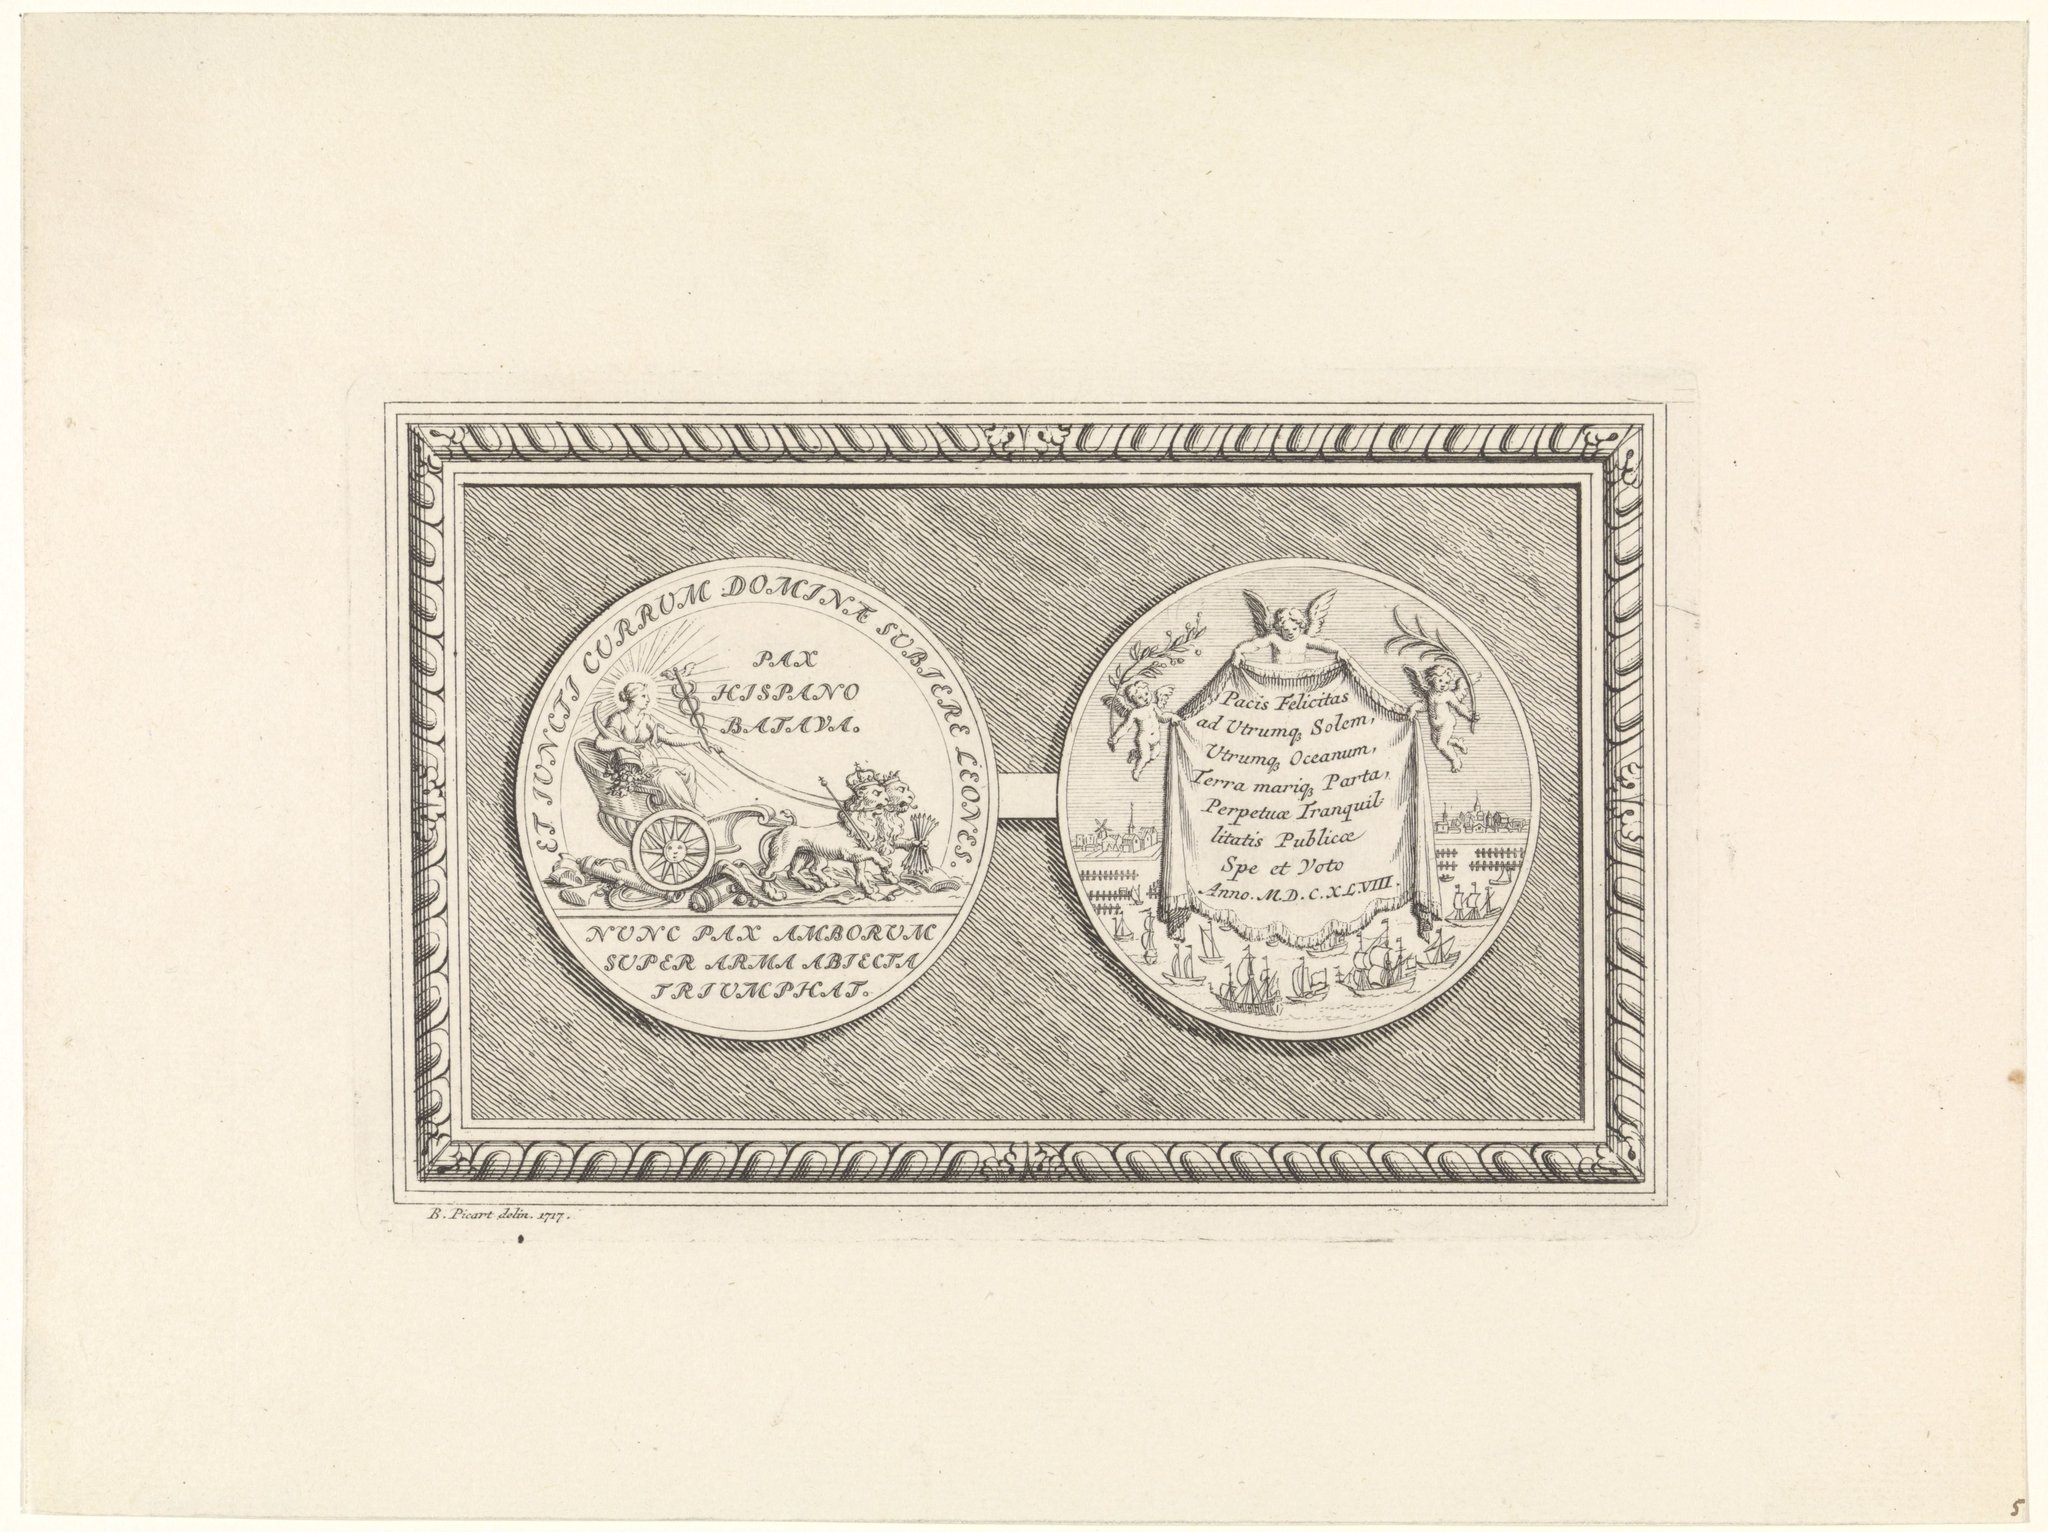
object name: print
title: Penning vervaardigd naar aanleiding van de Vrede van Münster, 1648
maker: bernard picart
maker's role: draughtsman, print maker, publisher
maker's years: 1673-1733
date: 1717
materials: paper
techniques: engraving, etching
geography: amsterdam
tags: symbols, allegories of peace, 'pax'; 'pace' (ripa), chariot, triumphal car, medal (considered as a piece of sculpture, regardless of its specific function)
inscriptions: collector's mark: Lugt 2228, number: ‘5’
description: Blad met de voor- en achterzijde van een penning. Links: Vrede rijdt over wapens heen in een triomfwagen voorgetrokken door de Nederlandse leeuwen. Rechts: Putti houden een draperie vast waarop in het Latijn de Vrede van Münster wordt bejubeld.